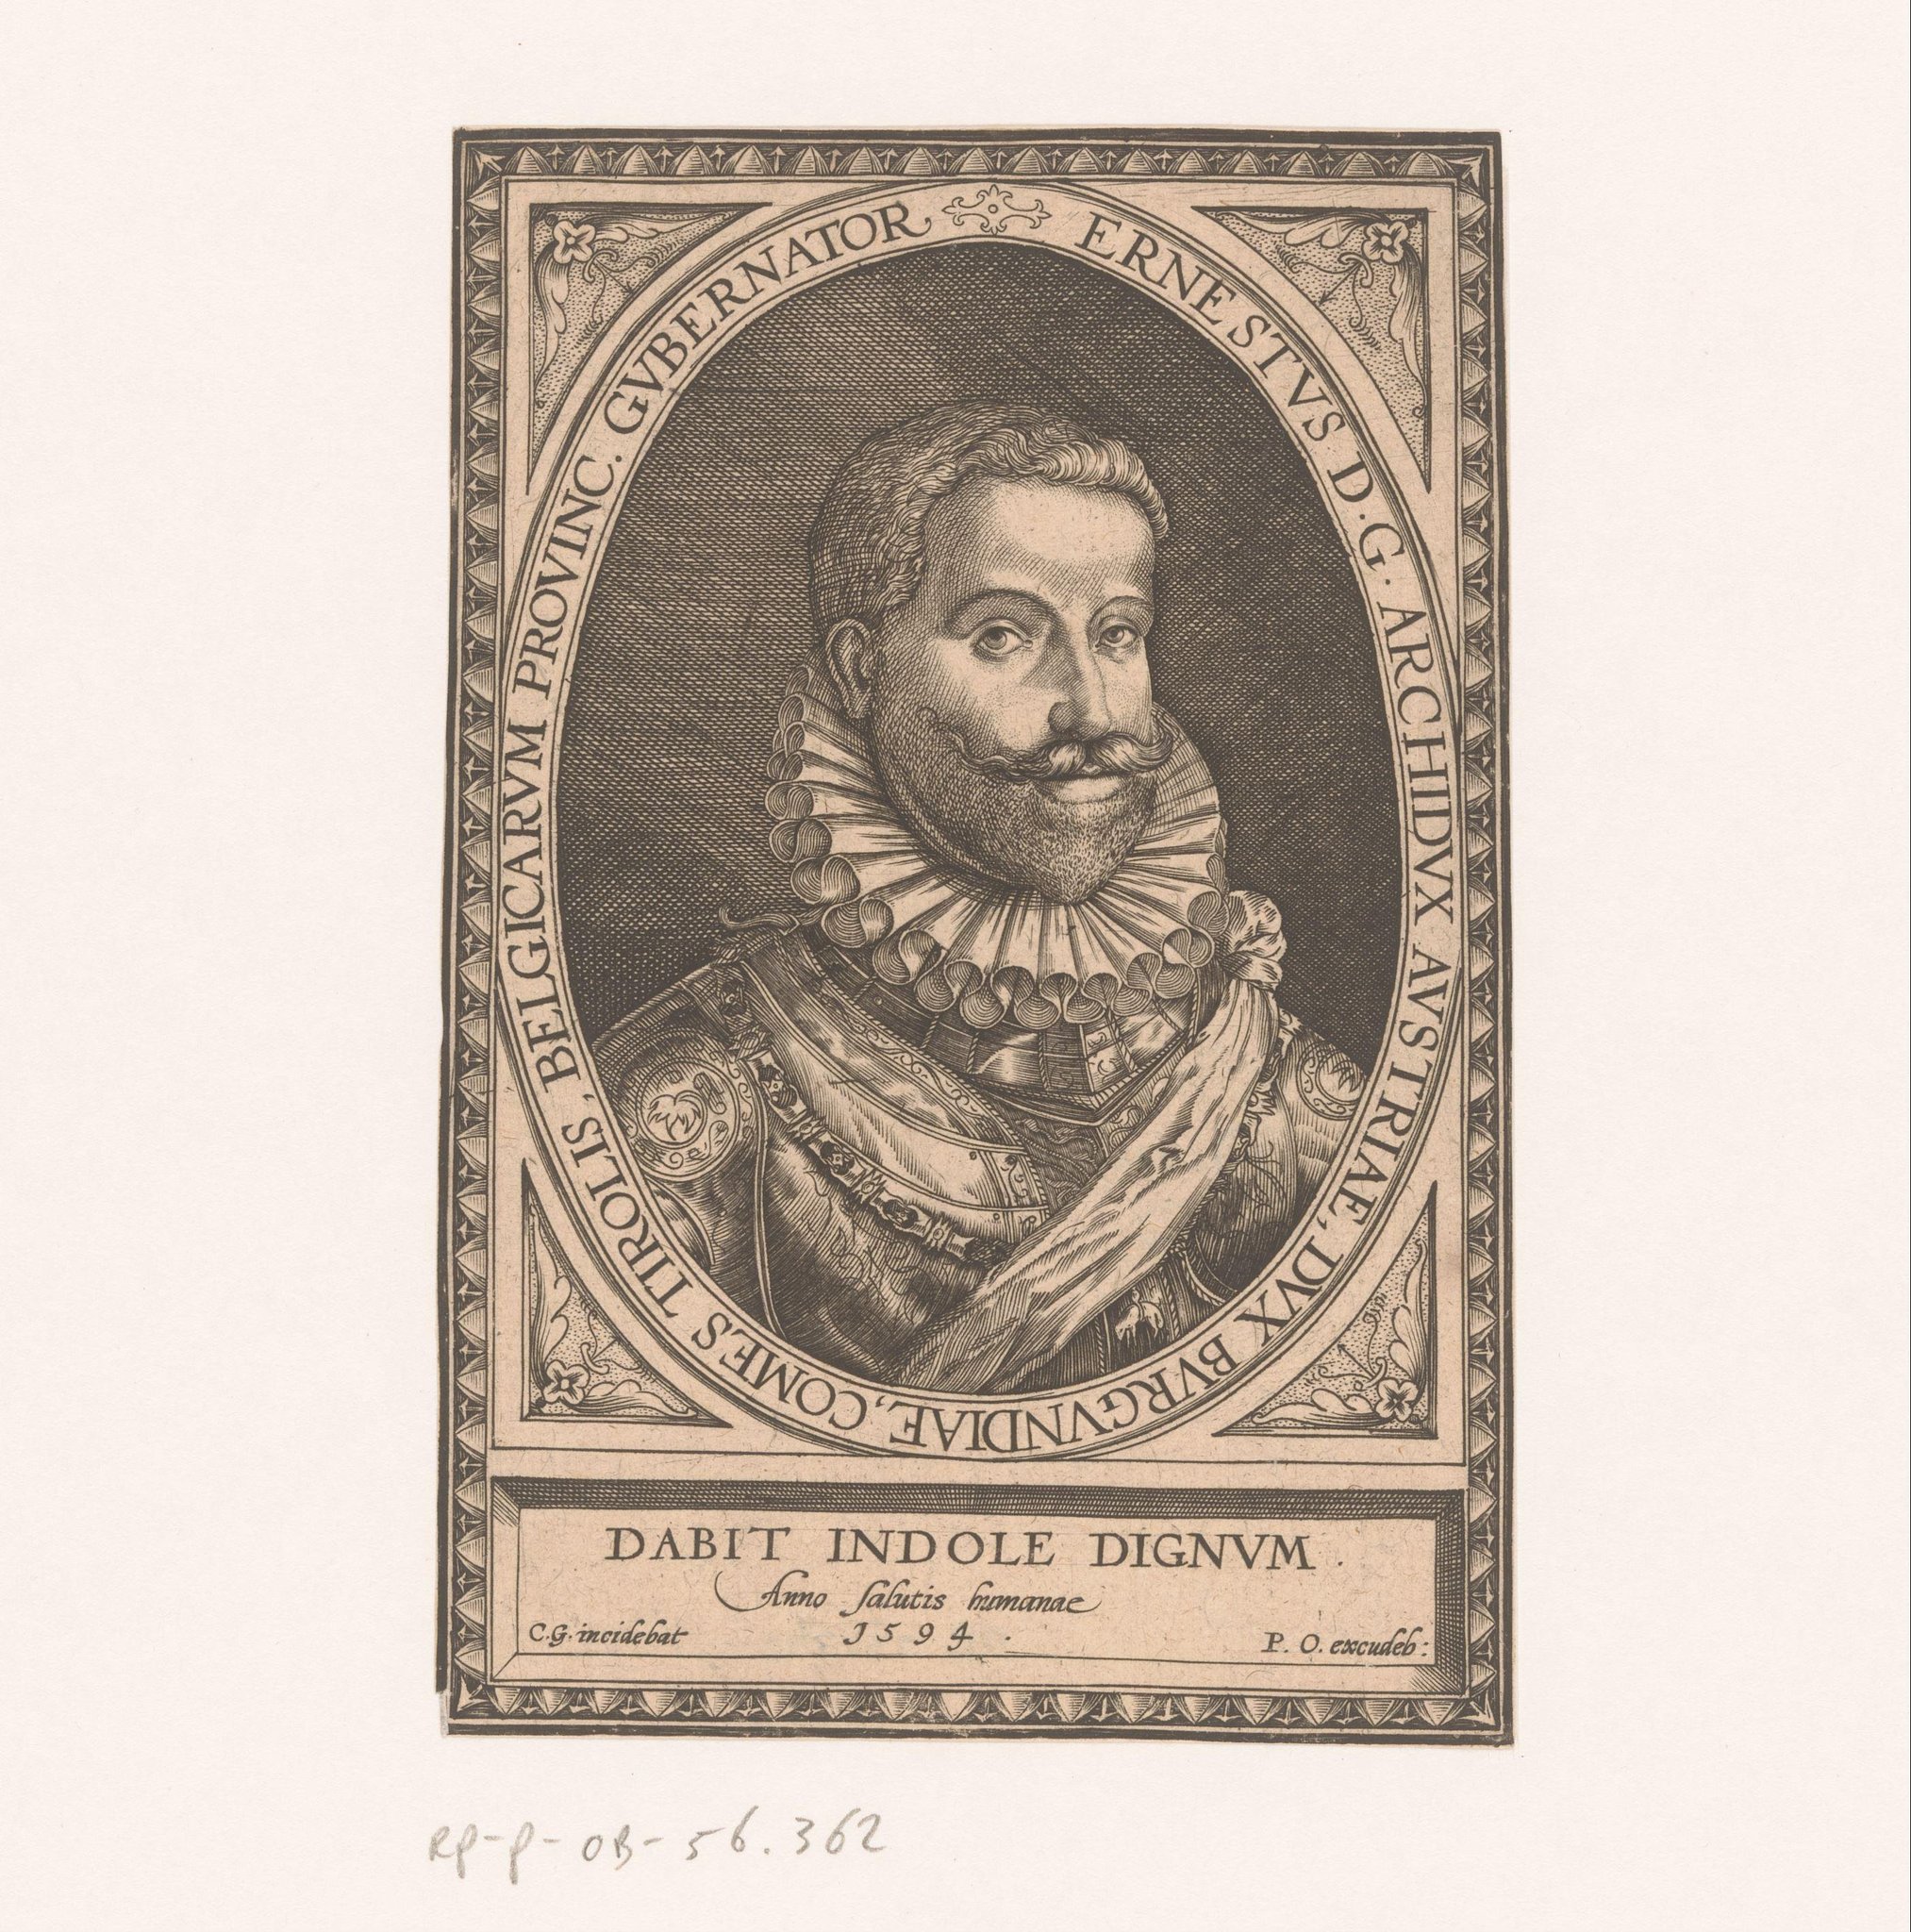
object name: print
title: Portret van Ernst, aartshertog van Oostenrijk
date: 1594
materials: paper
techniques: engraving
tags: vienna, brussels, historical persons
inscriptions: collector's mark: Lugt 964, collector's mark: Lugt 2228